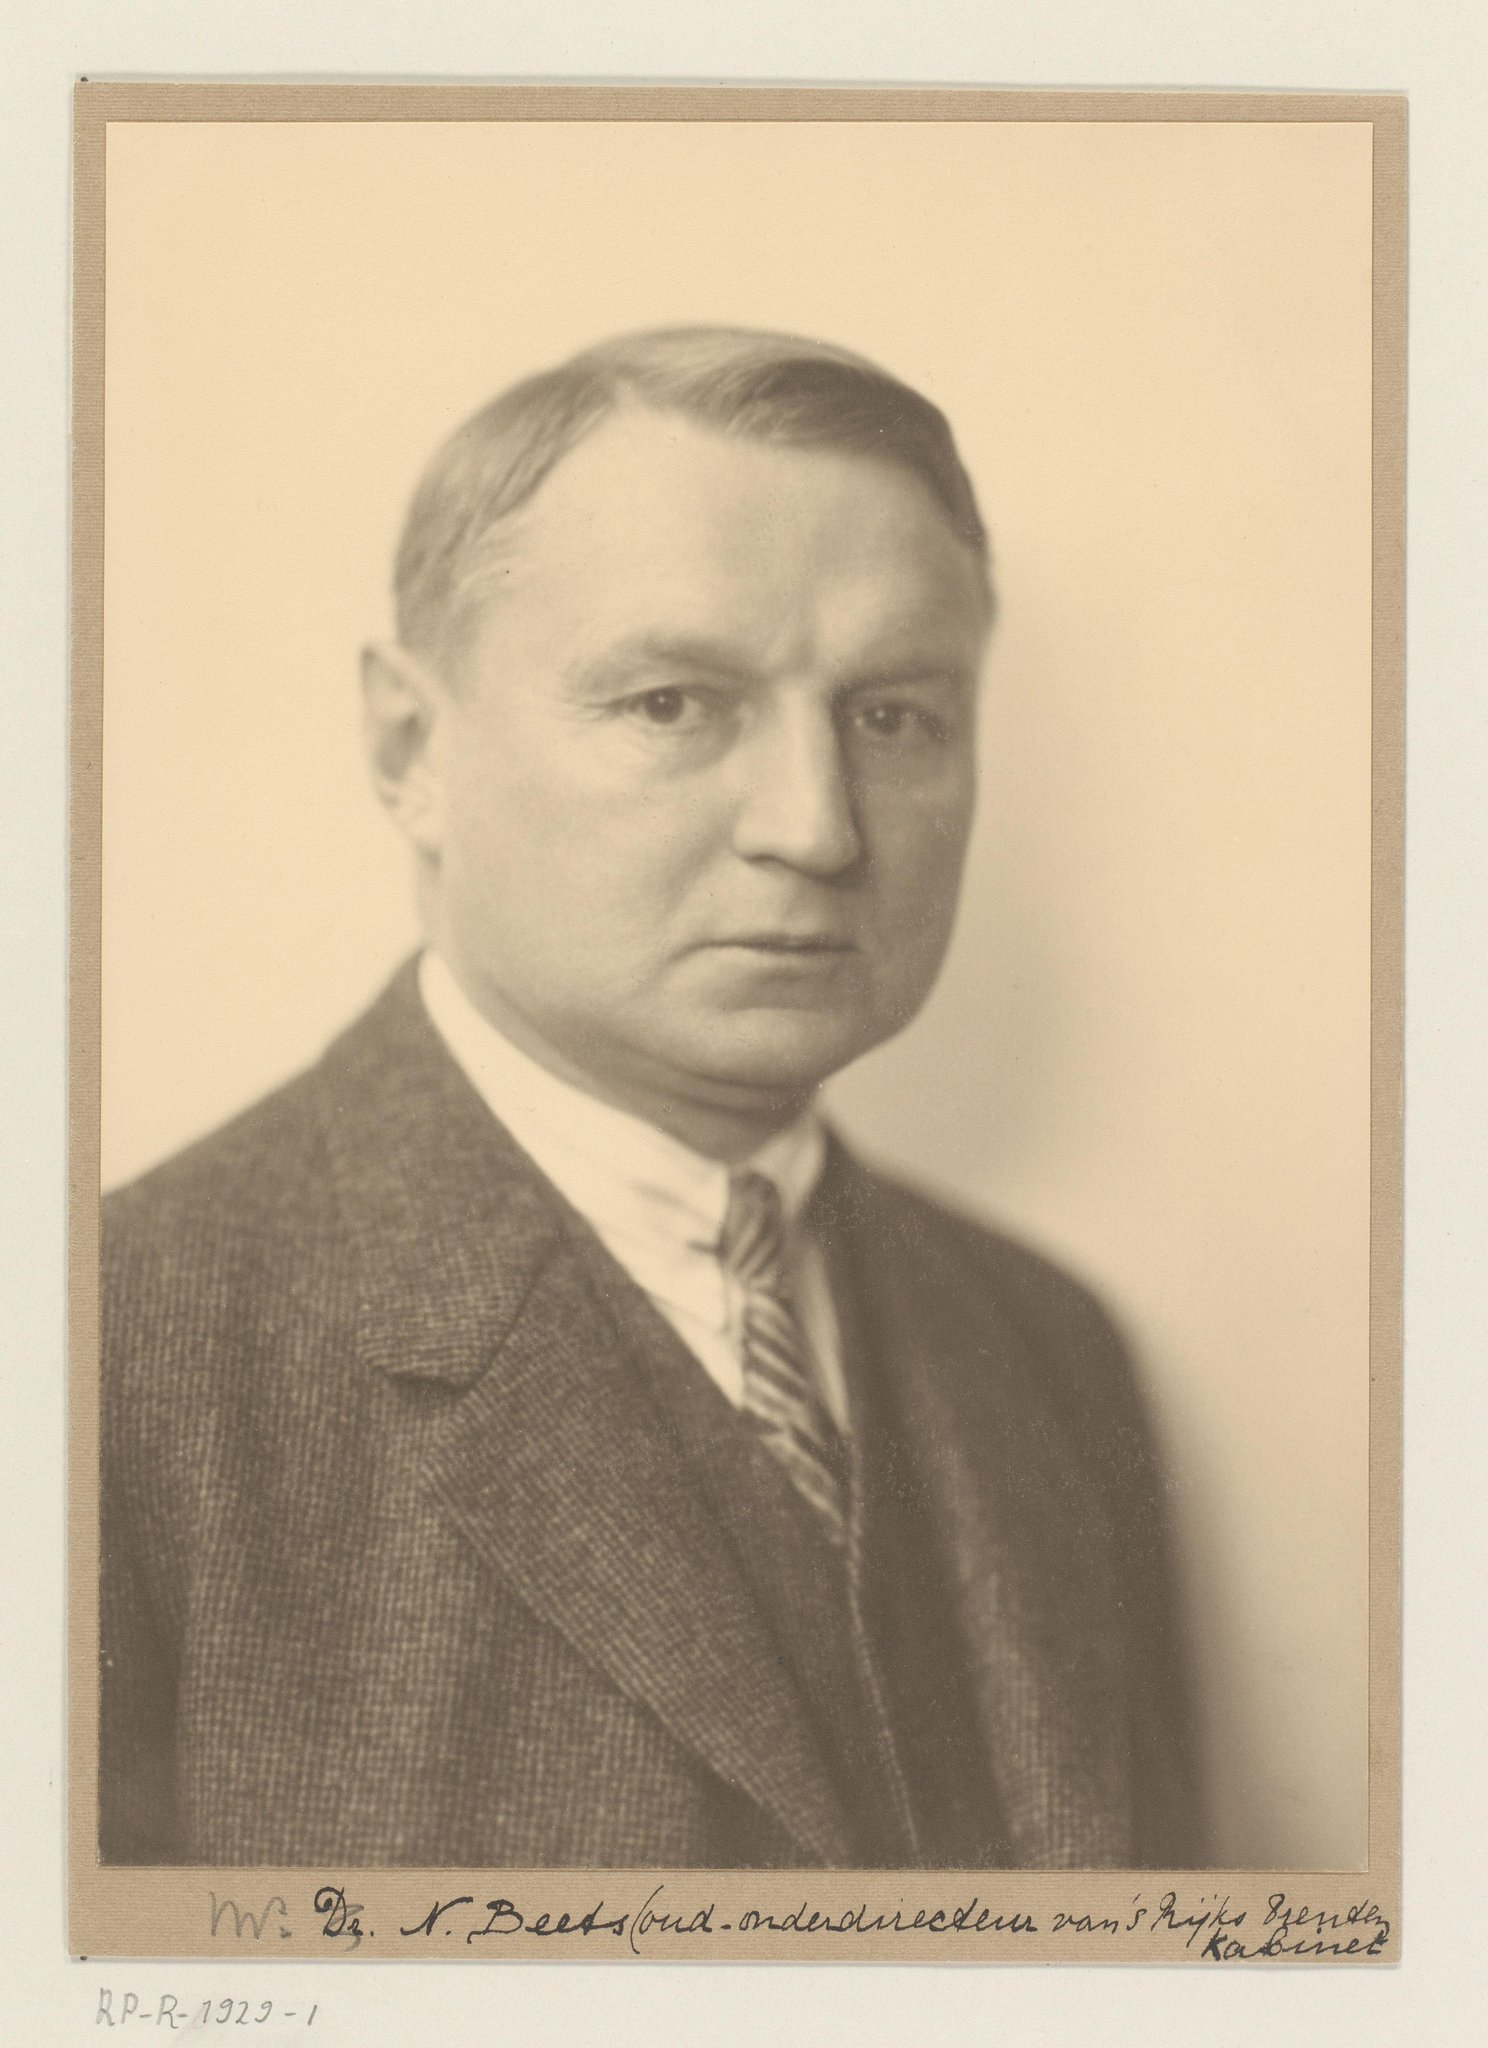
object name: photograph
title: Portret van Nicolaas Beets, oud-onderdirecteur van het Rijksprentenkabinet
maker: Anonymous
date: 1920-1929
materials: paper, cardboard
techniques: gelatin silver print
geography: amsterdam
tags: batavia, amsterdam, historical persons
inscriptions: inscription: ‘Mr. Dr. N. beets (oud-onderdirecteur van 's Rijks Prenten/ Kabinet’, number: ‘29-1’